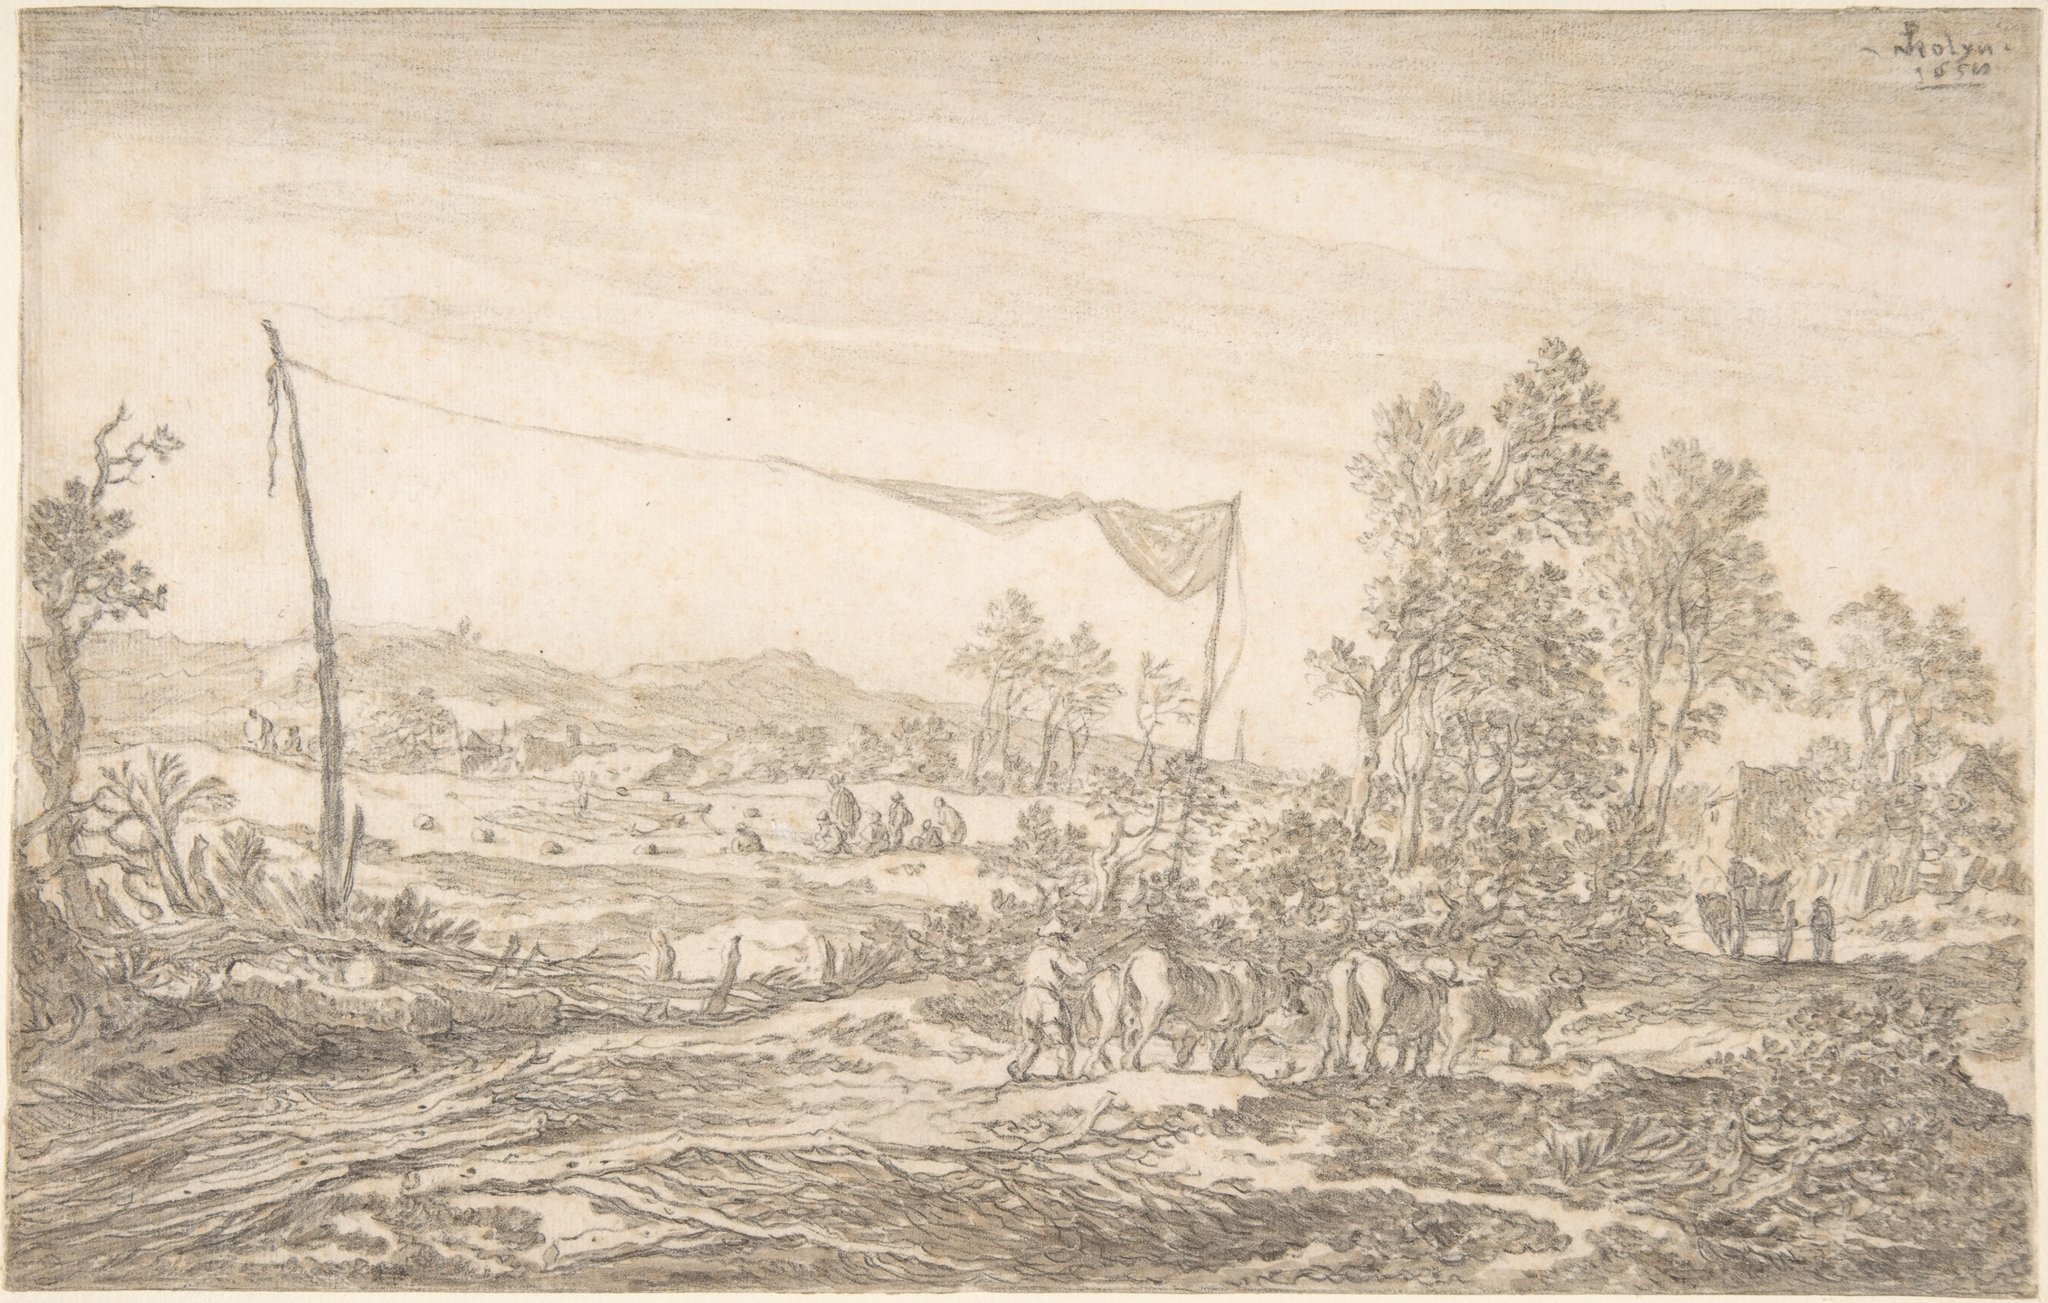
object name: drawing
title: Landscape with Figures and Cattle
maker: pieter de molijn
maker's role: artist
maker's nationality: dutch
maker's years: 1595-1661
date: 1658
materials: chalk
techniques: brush, wash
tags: human figures,cows,landscapes,trees